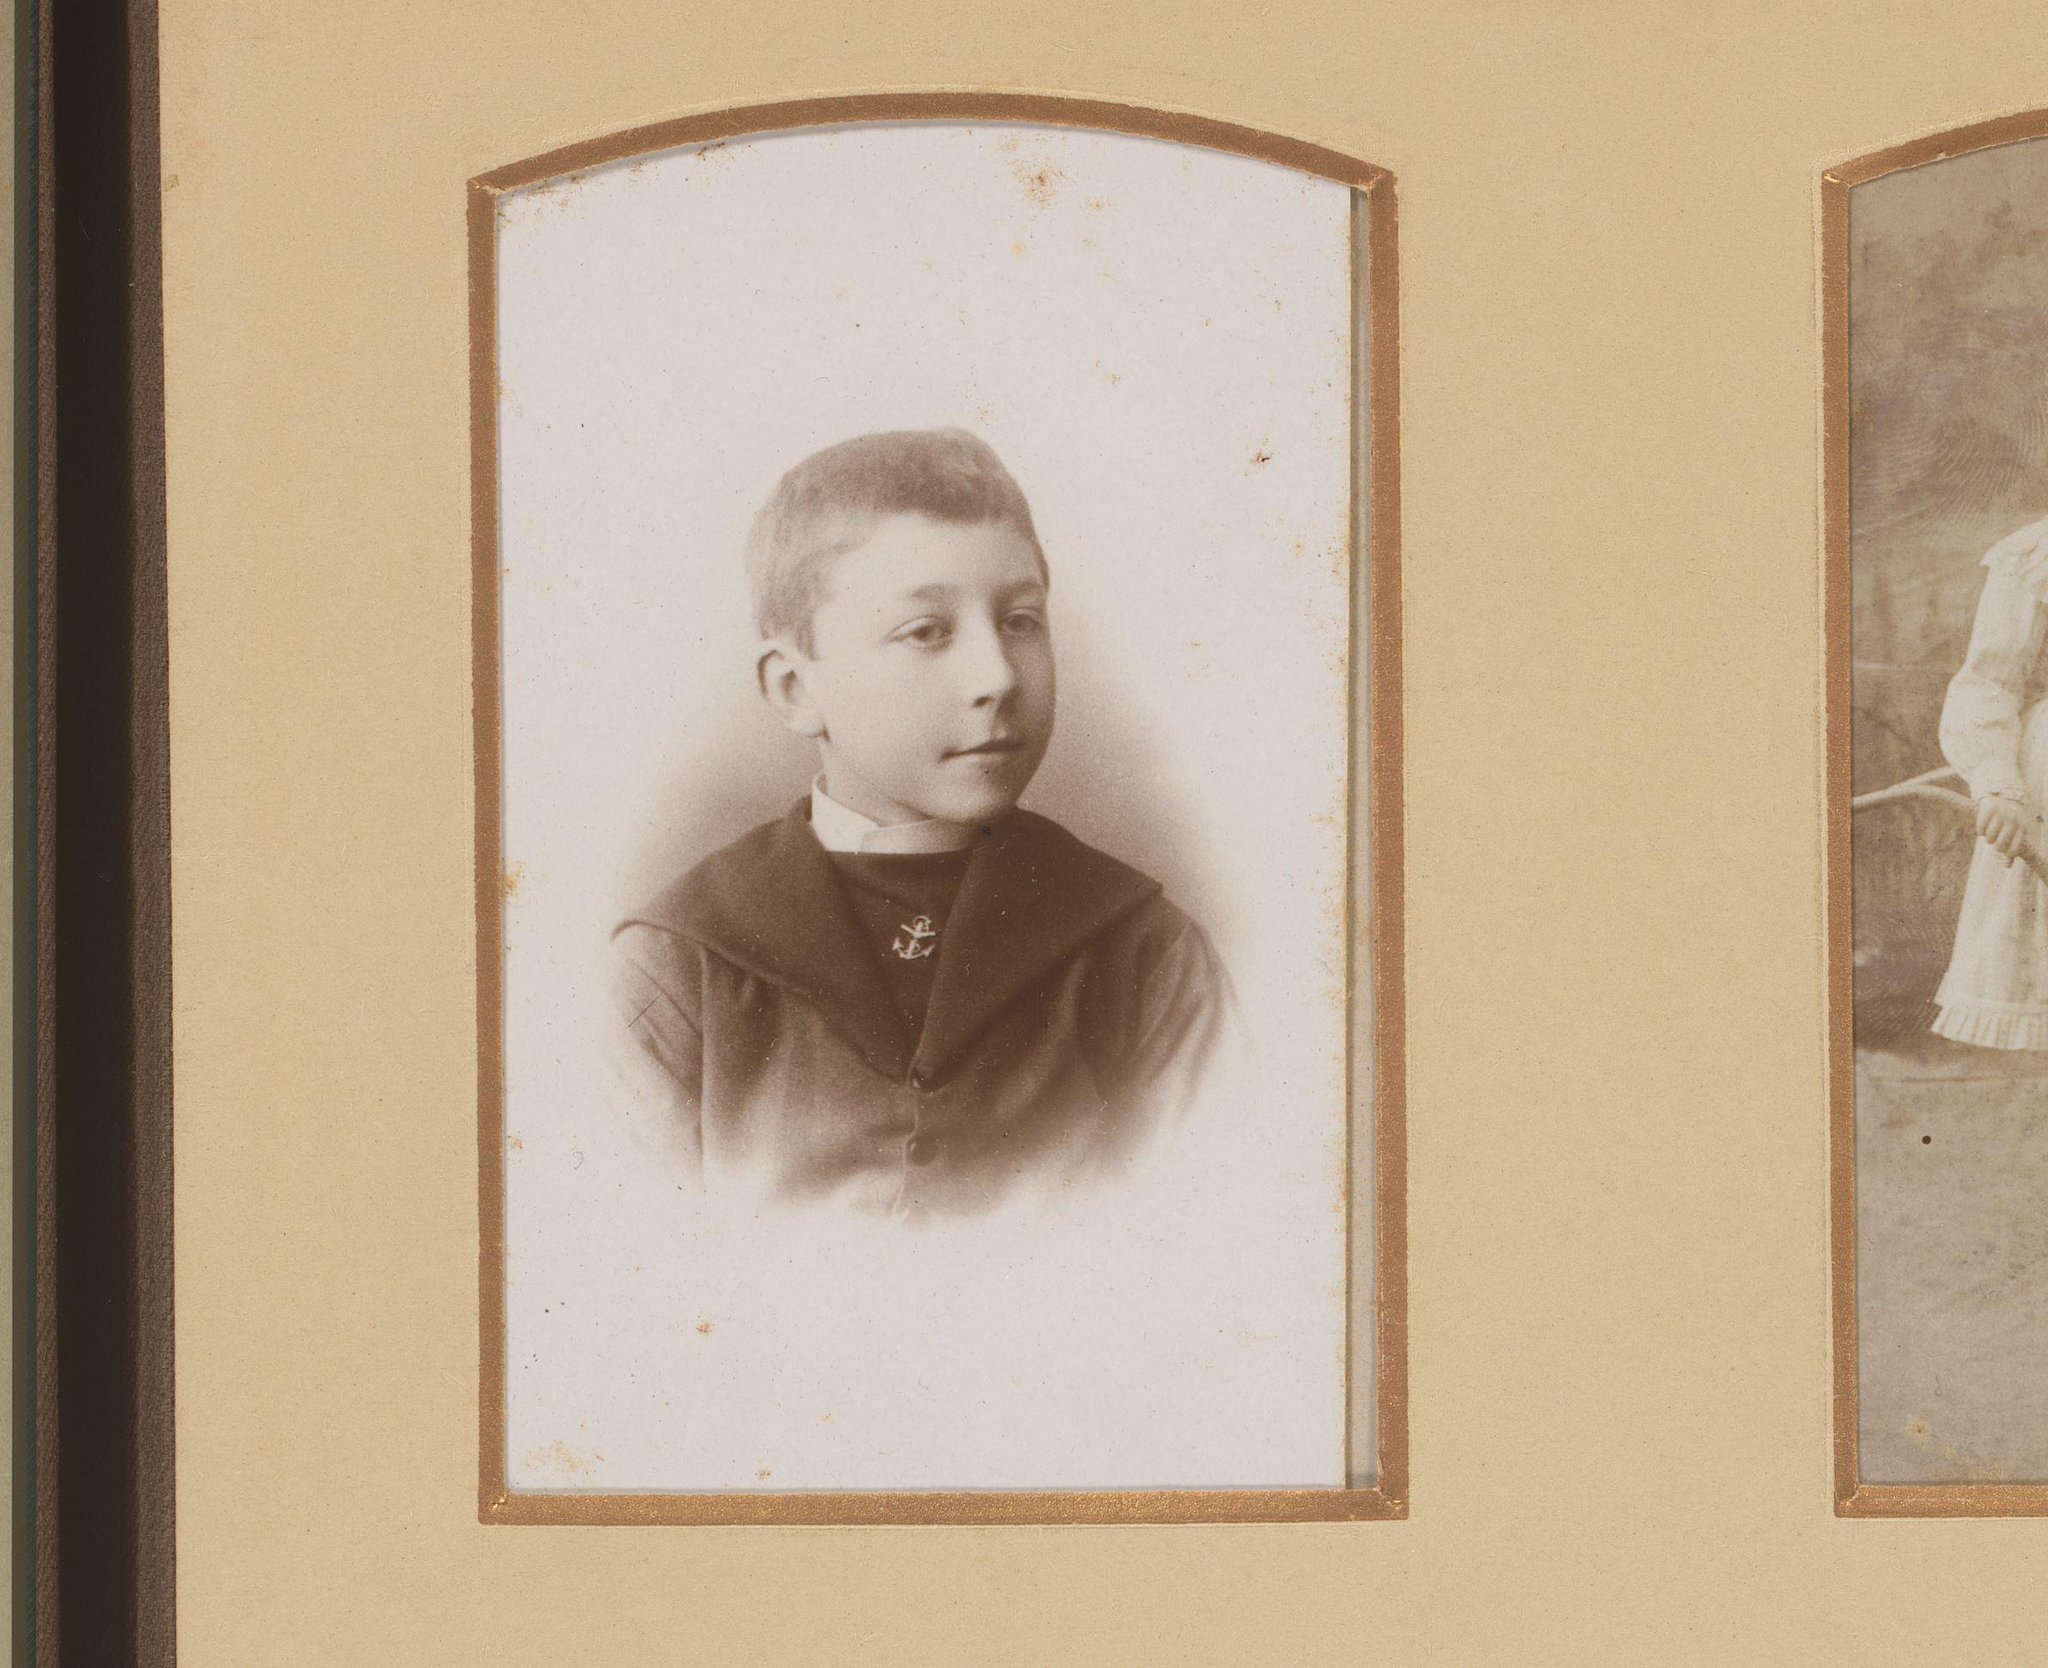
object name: carte de visite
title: Portret van een jongen in matrozenpak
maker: gerrit leenheer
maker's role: fotograaf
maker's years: 1874-1940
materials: cardboard, photographic support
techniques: collodion silver print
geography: amsterdam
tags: historical persons - bb - woman, ensemble of pieces of clothing: sailor suit, boy (child between toddler and youth)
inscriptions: inscription: ‘Bekroond Gouden Medaille/ Leuven 1900/ De Doelen/ G. Leenheer/ Amstel 2 hoek Sophiaplein/ Amsterdam’